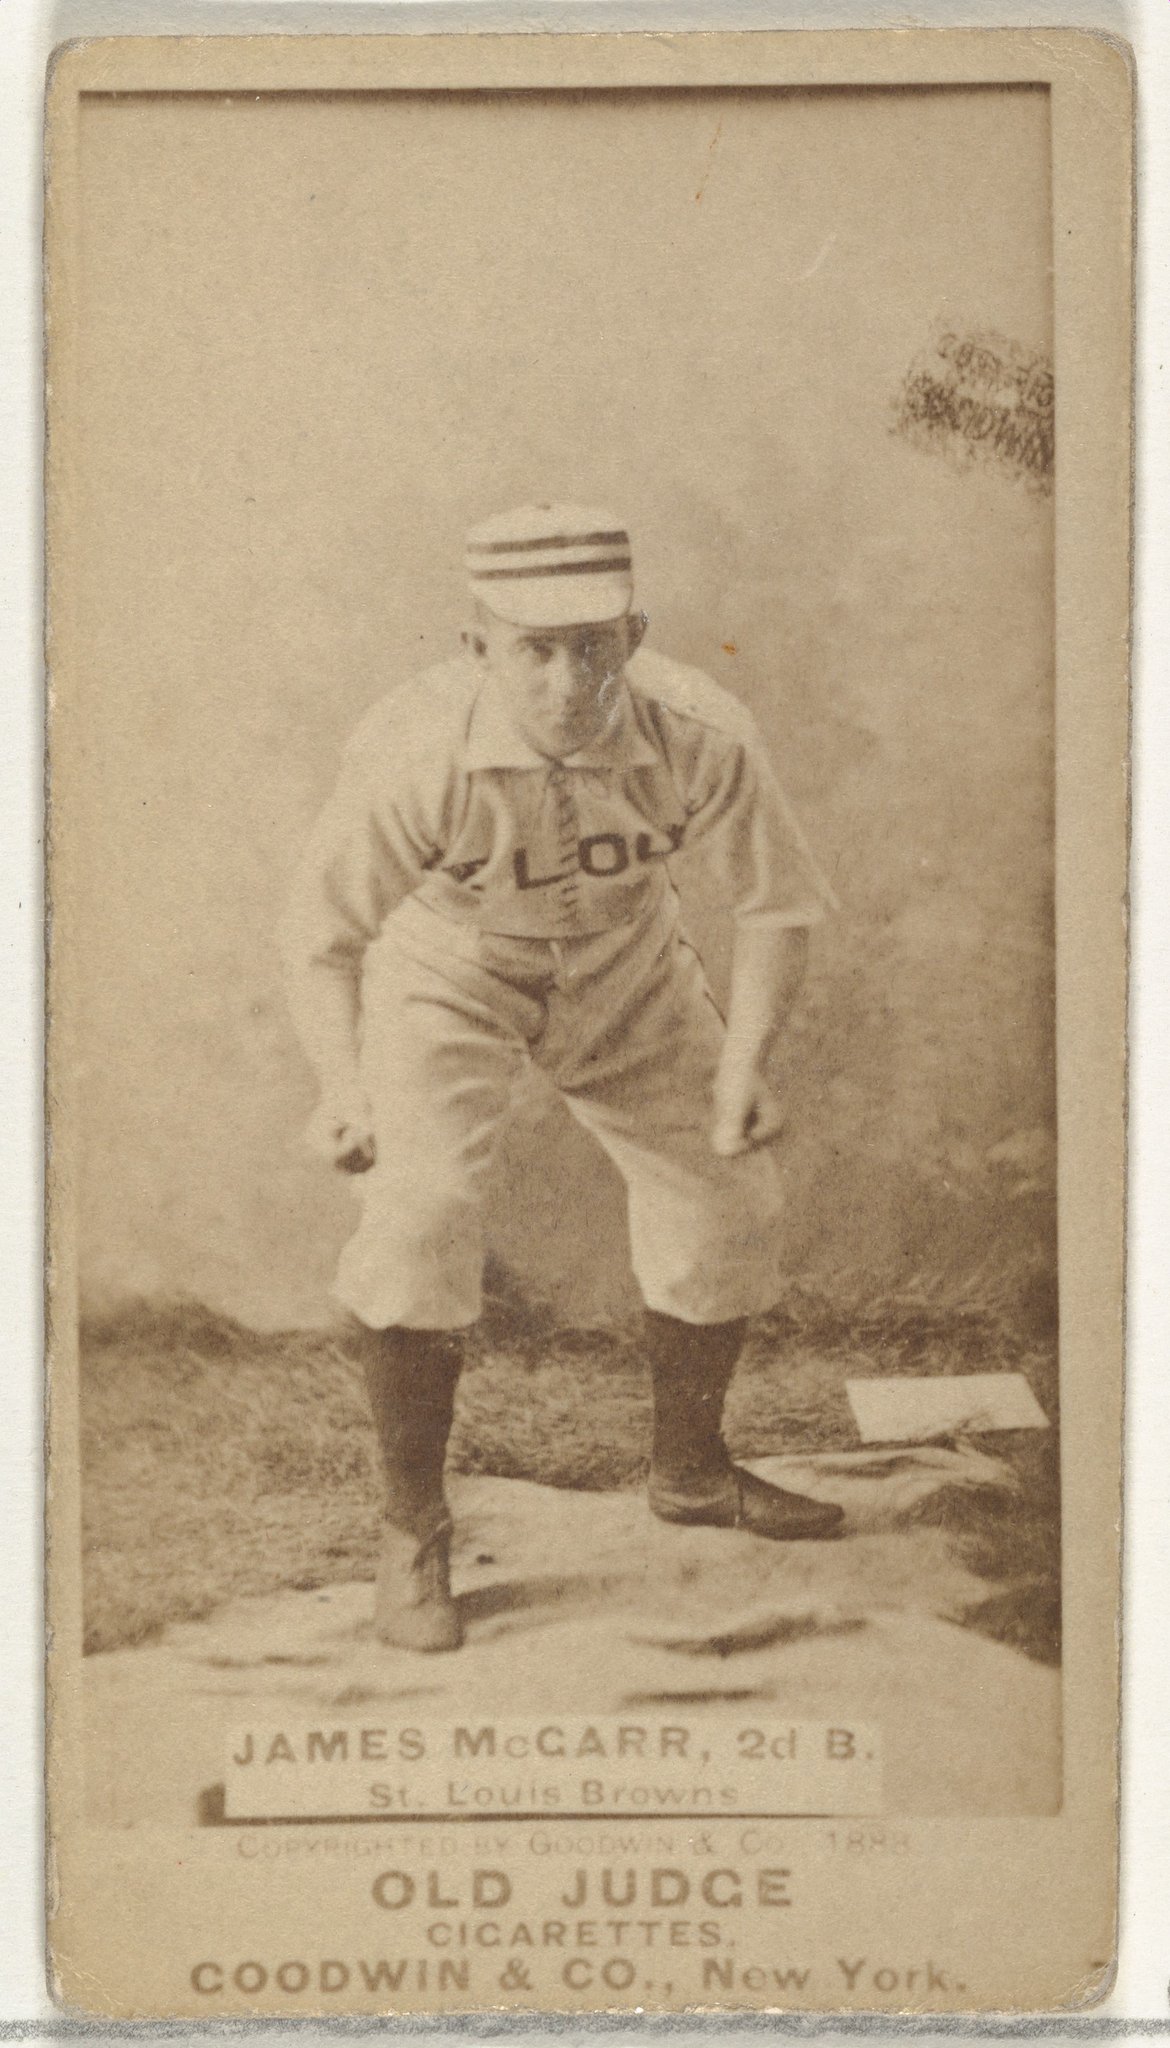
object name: baseball card, photograph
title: Chippy McGarr, 2nd Base, St. Louis Browns, from the Old Judge series (N172) for Old Judge Cigarettes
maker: goodwin & company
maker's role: publisher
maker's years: 1850-1950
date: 1888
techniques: albumen silver print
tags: men,portraits,baseball,athletes